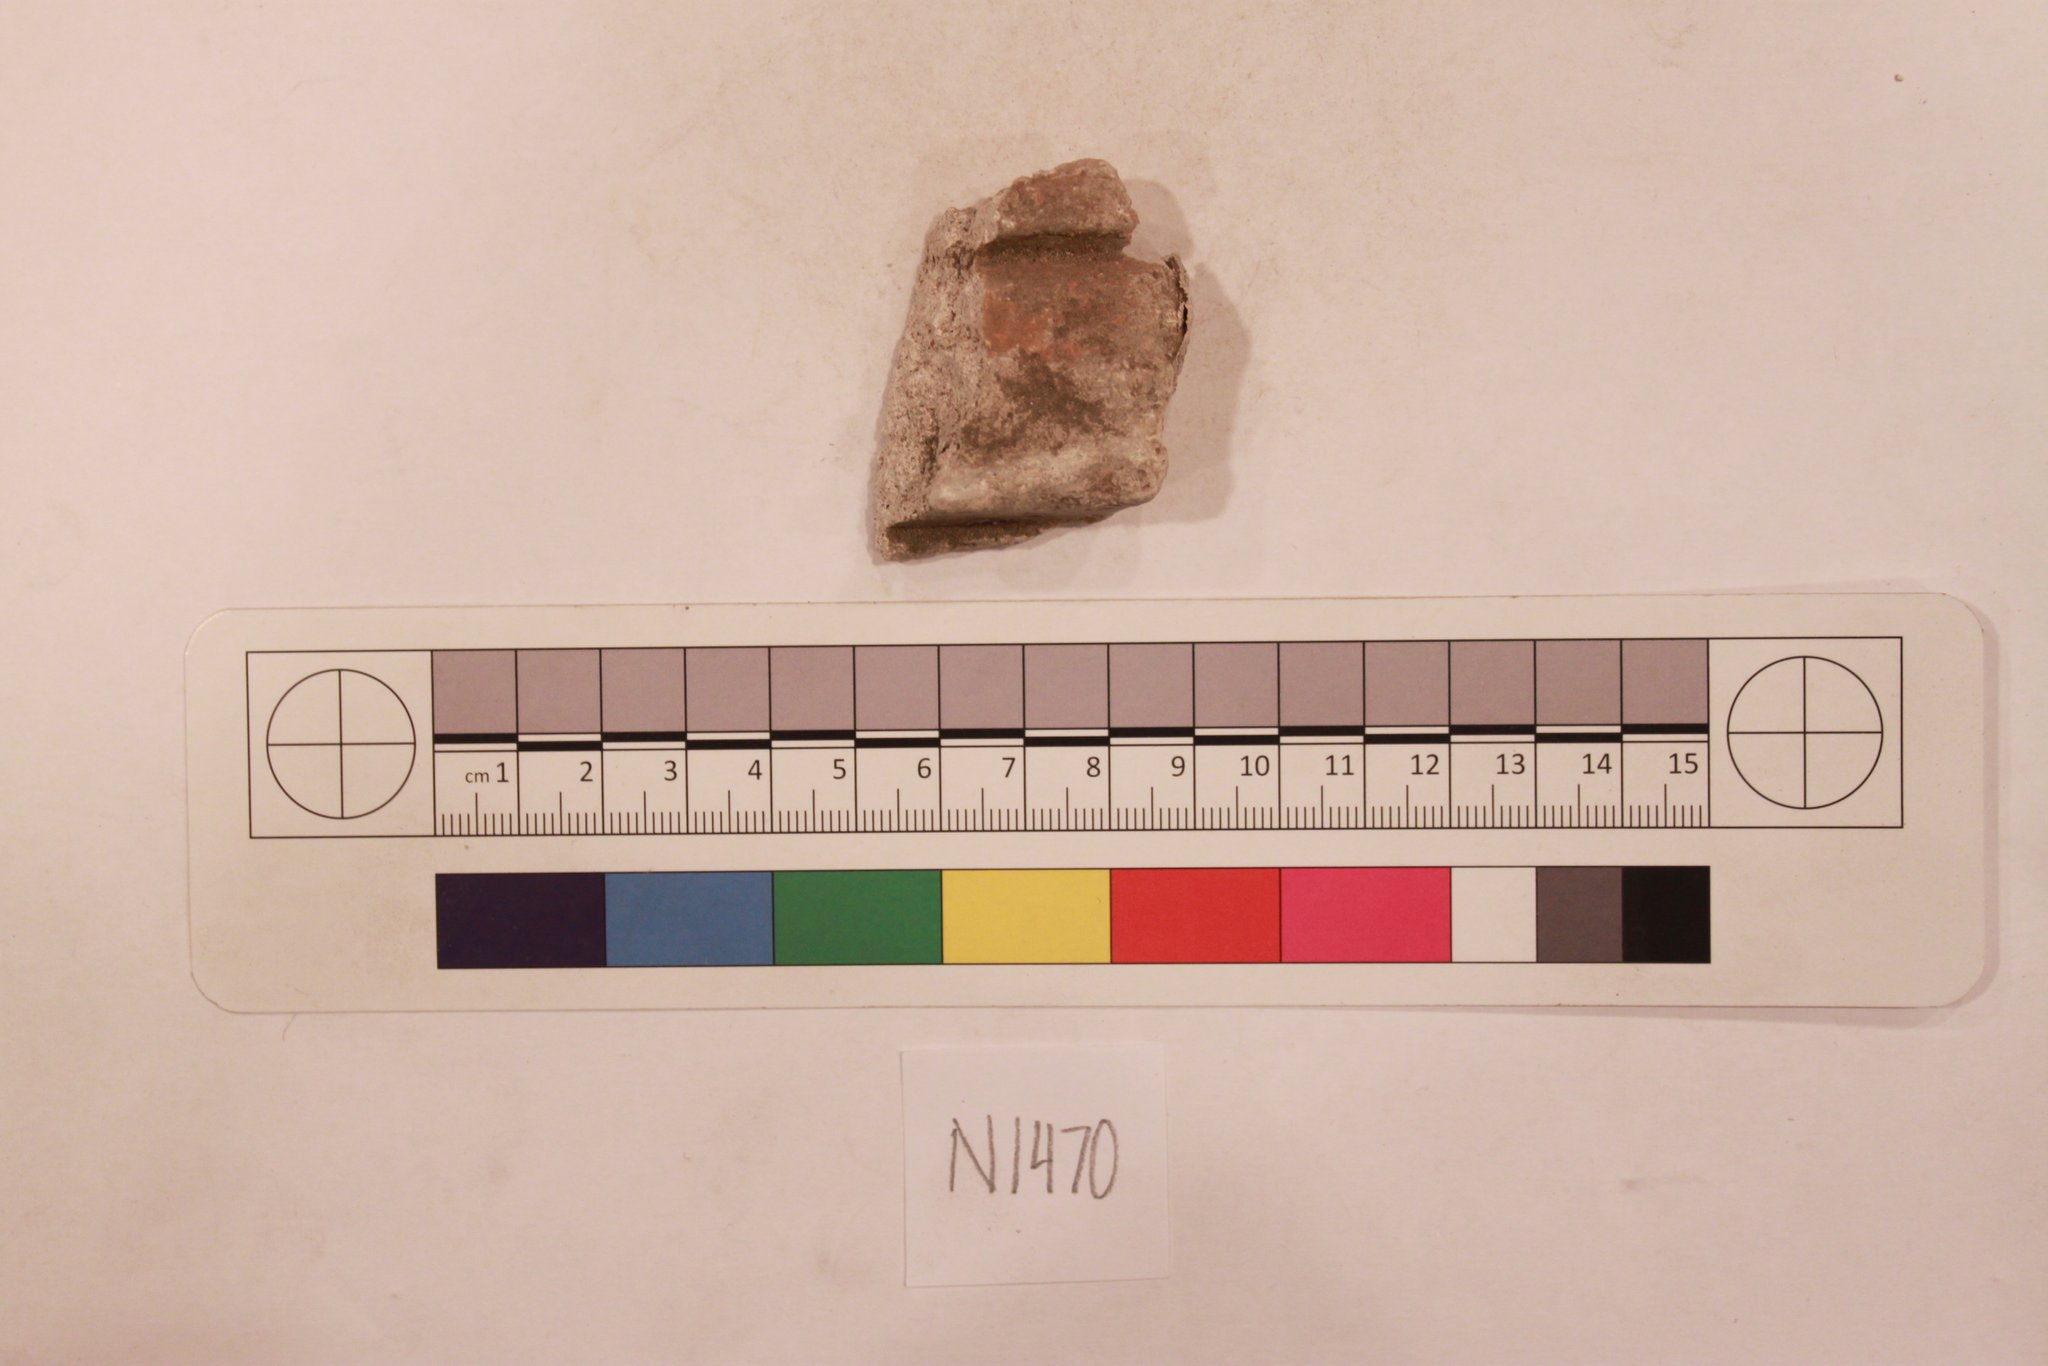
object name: fragment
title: Stucco Fragment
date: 701-1200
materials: plaster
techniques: carving, painting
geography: iran